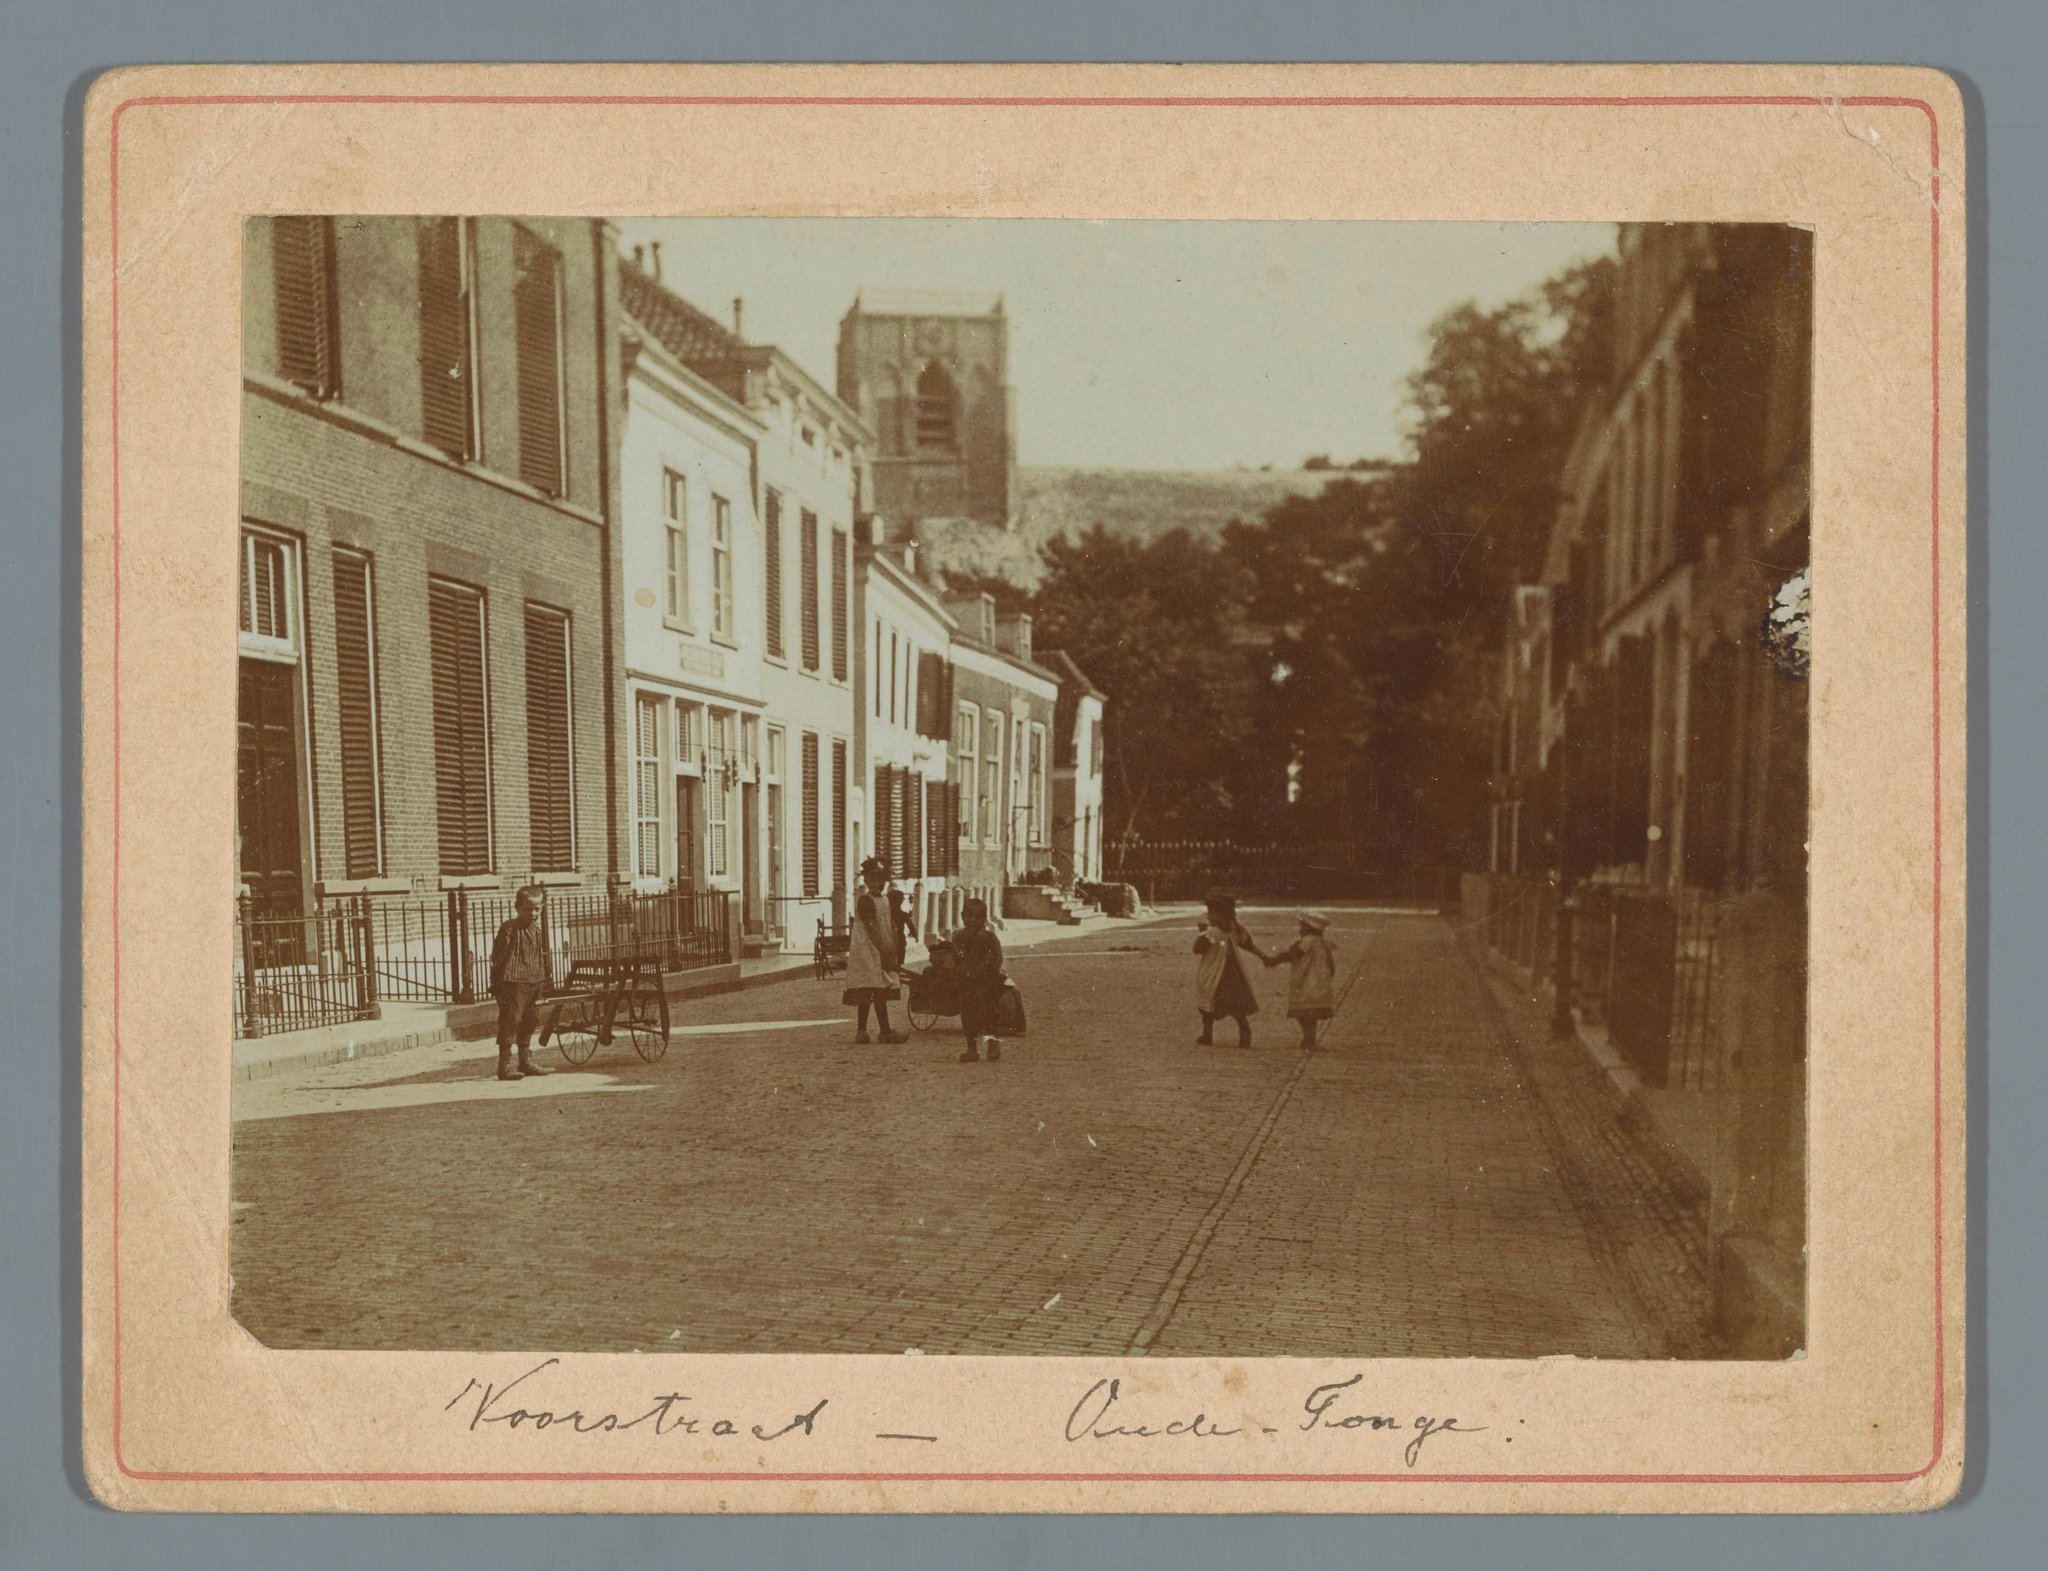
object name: photograph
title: Gezicht op de Voorstraat te Oude-Tongen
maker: Anonymous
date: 1880-1940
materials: paper, cardboard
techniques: collodion silver print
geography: oude-tonge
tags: street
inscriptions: inscription: ‘Voorstraat - Oude-Tonge’, inscription: ‘Jan [...]/ Zoo juist het nieuws gelezen in de courant/ (...)’